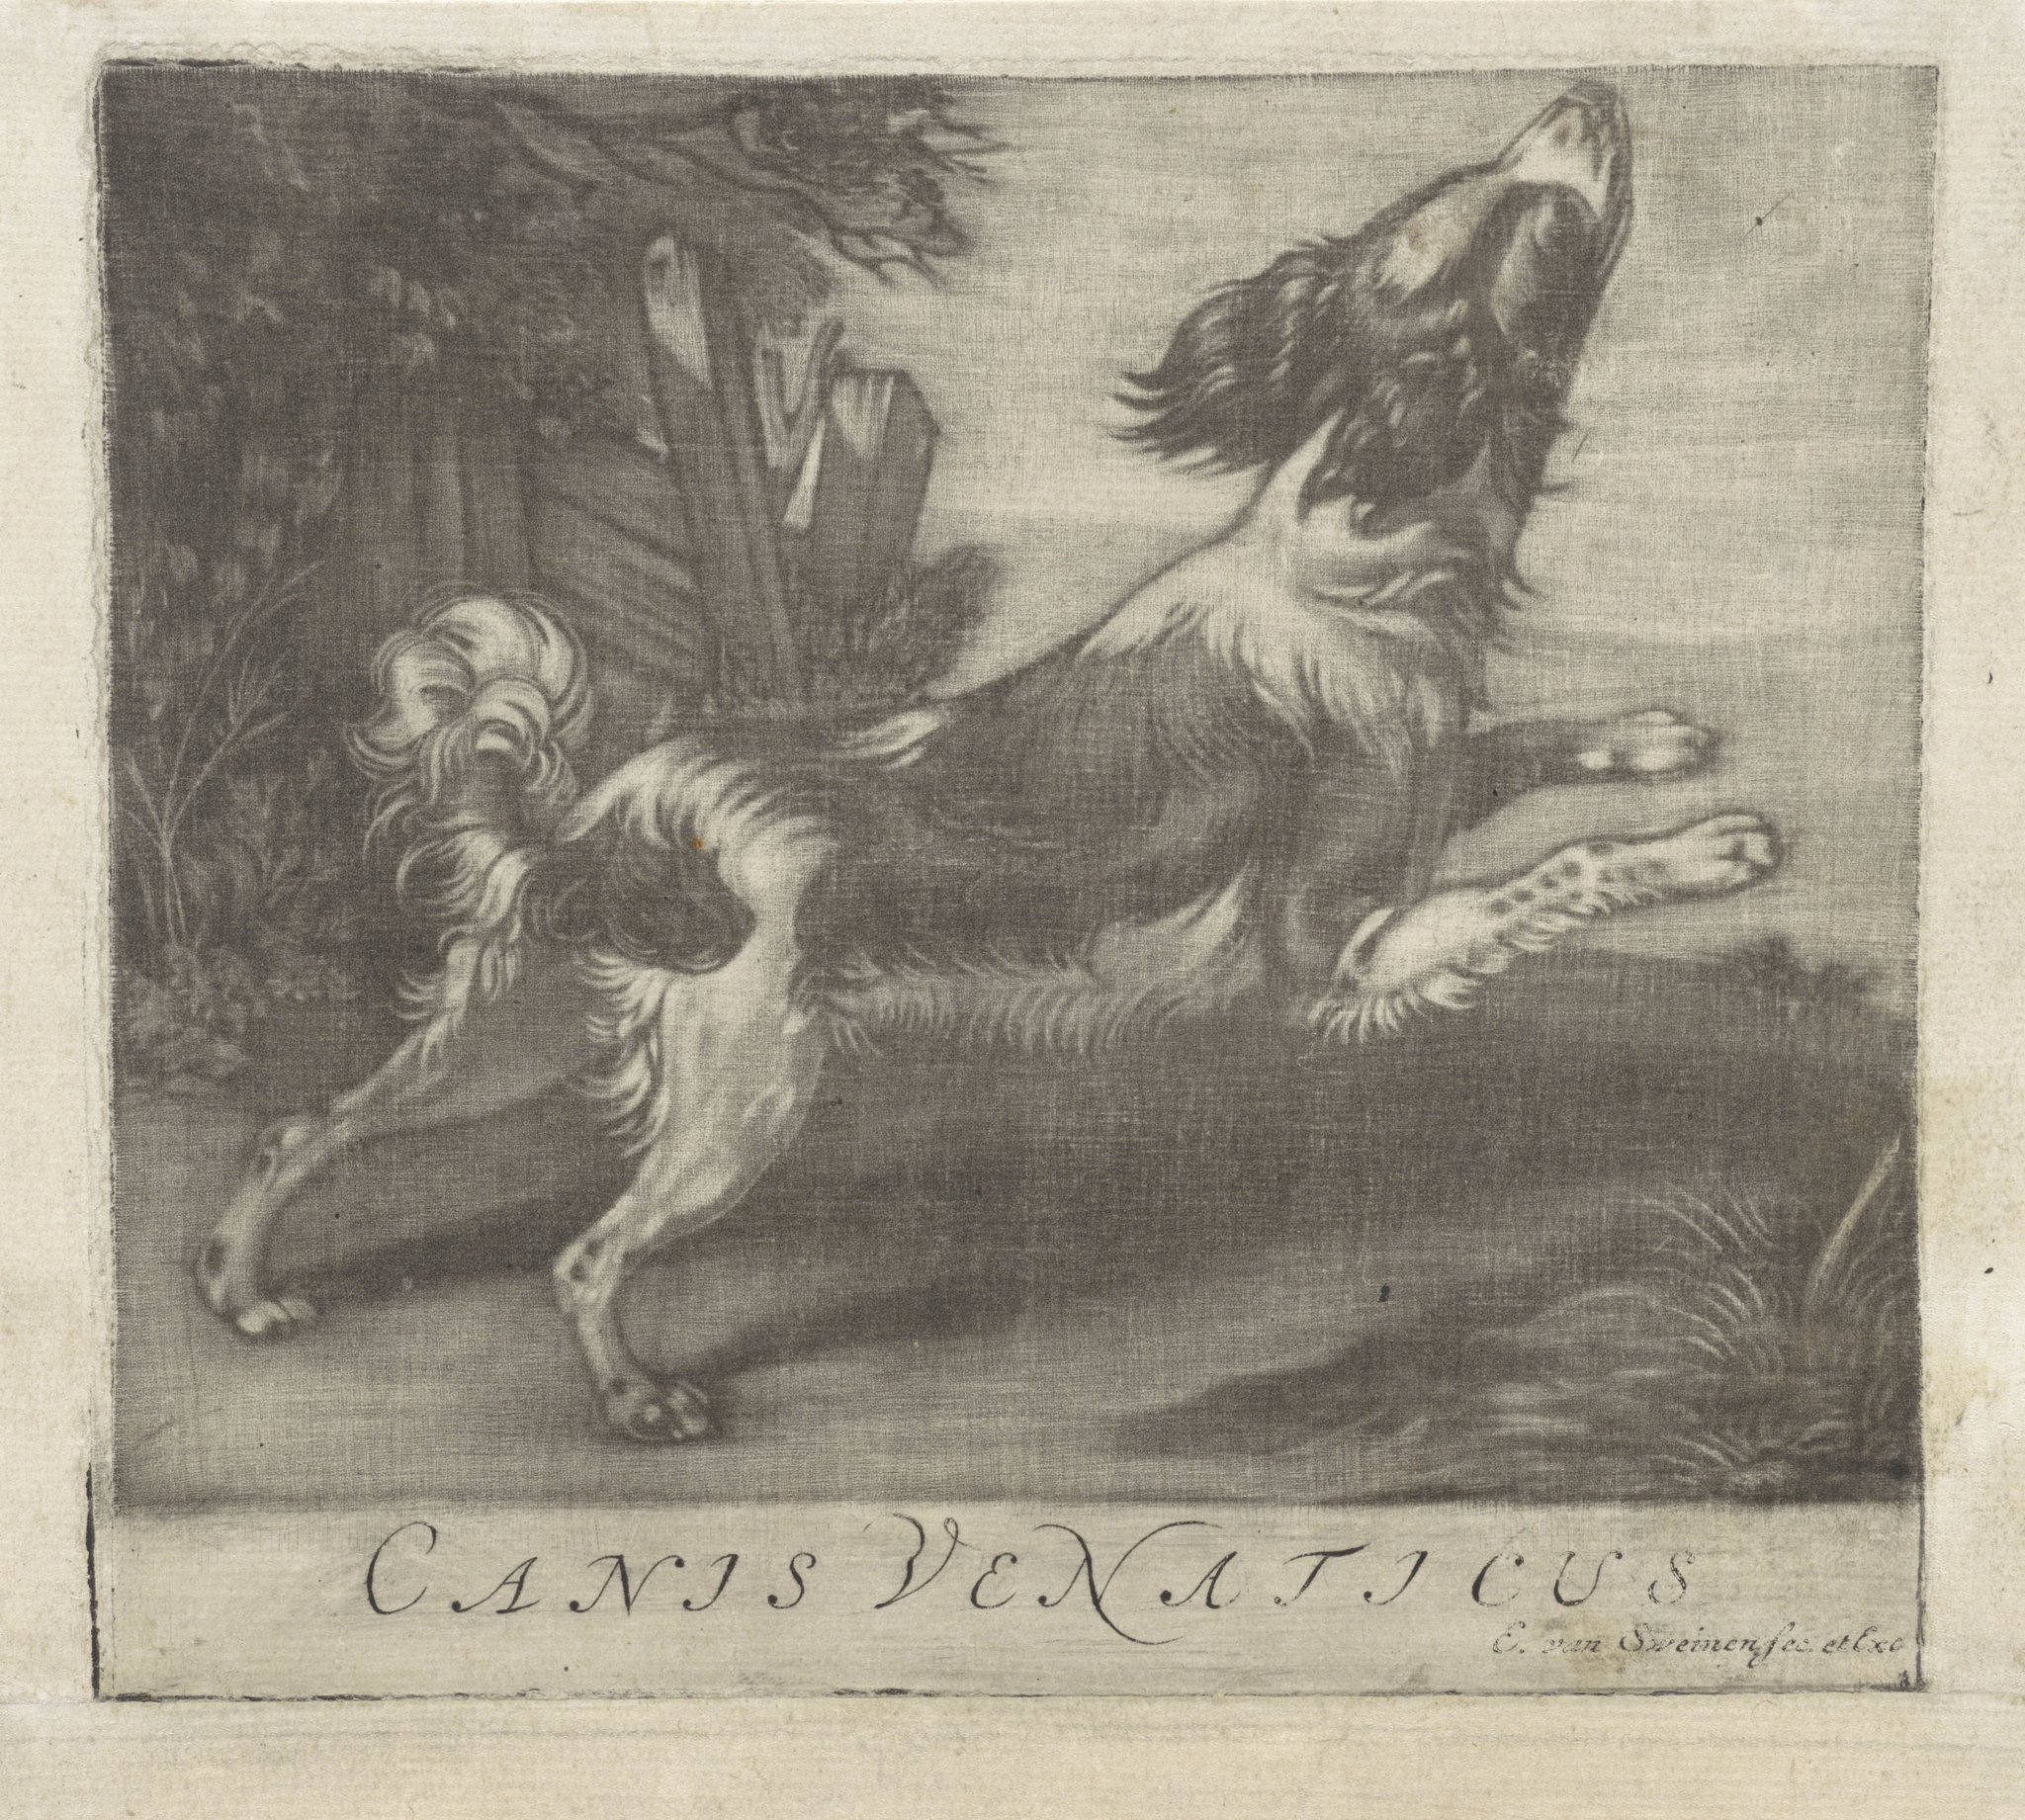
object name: print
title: Canis Venaticus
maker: evert van sweinen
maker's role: print maker, publisher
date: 1686-1710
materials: paper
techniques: mezzotint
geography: amsterdam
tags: dog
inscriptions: collector's mark: Lugt 2228